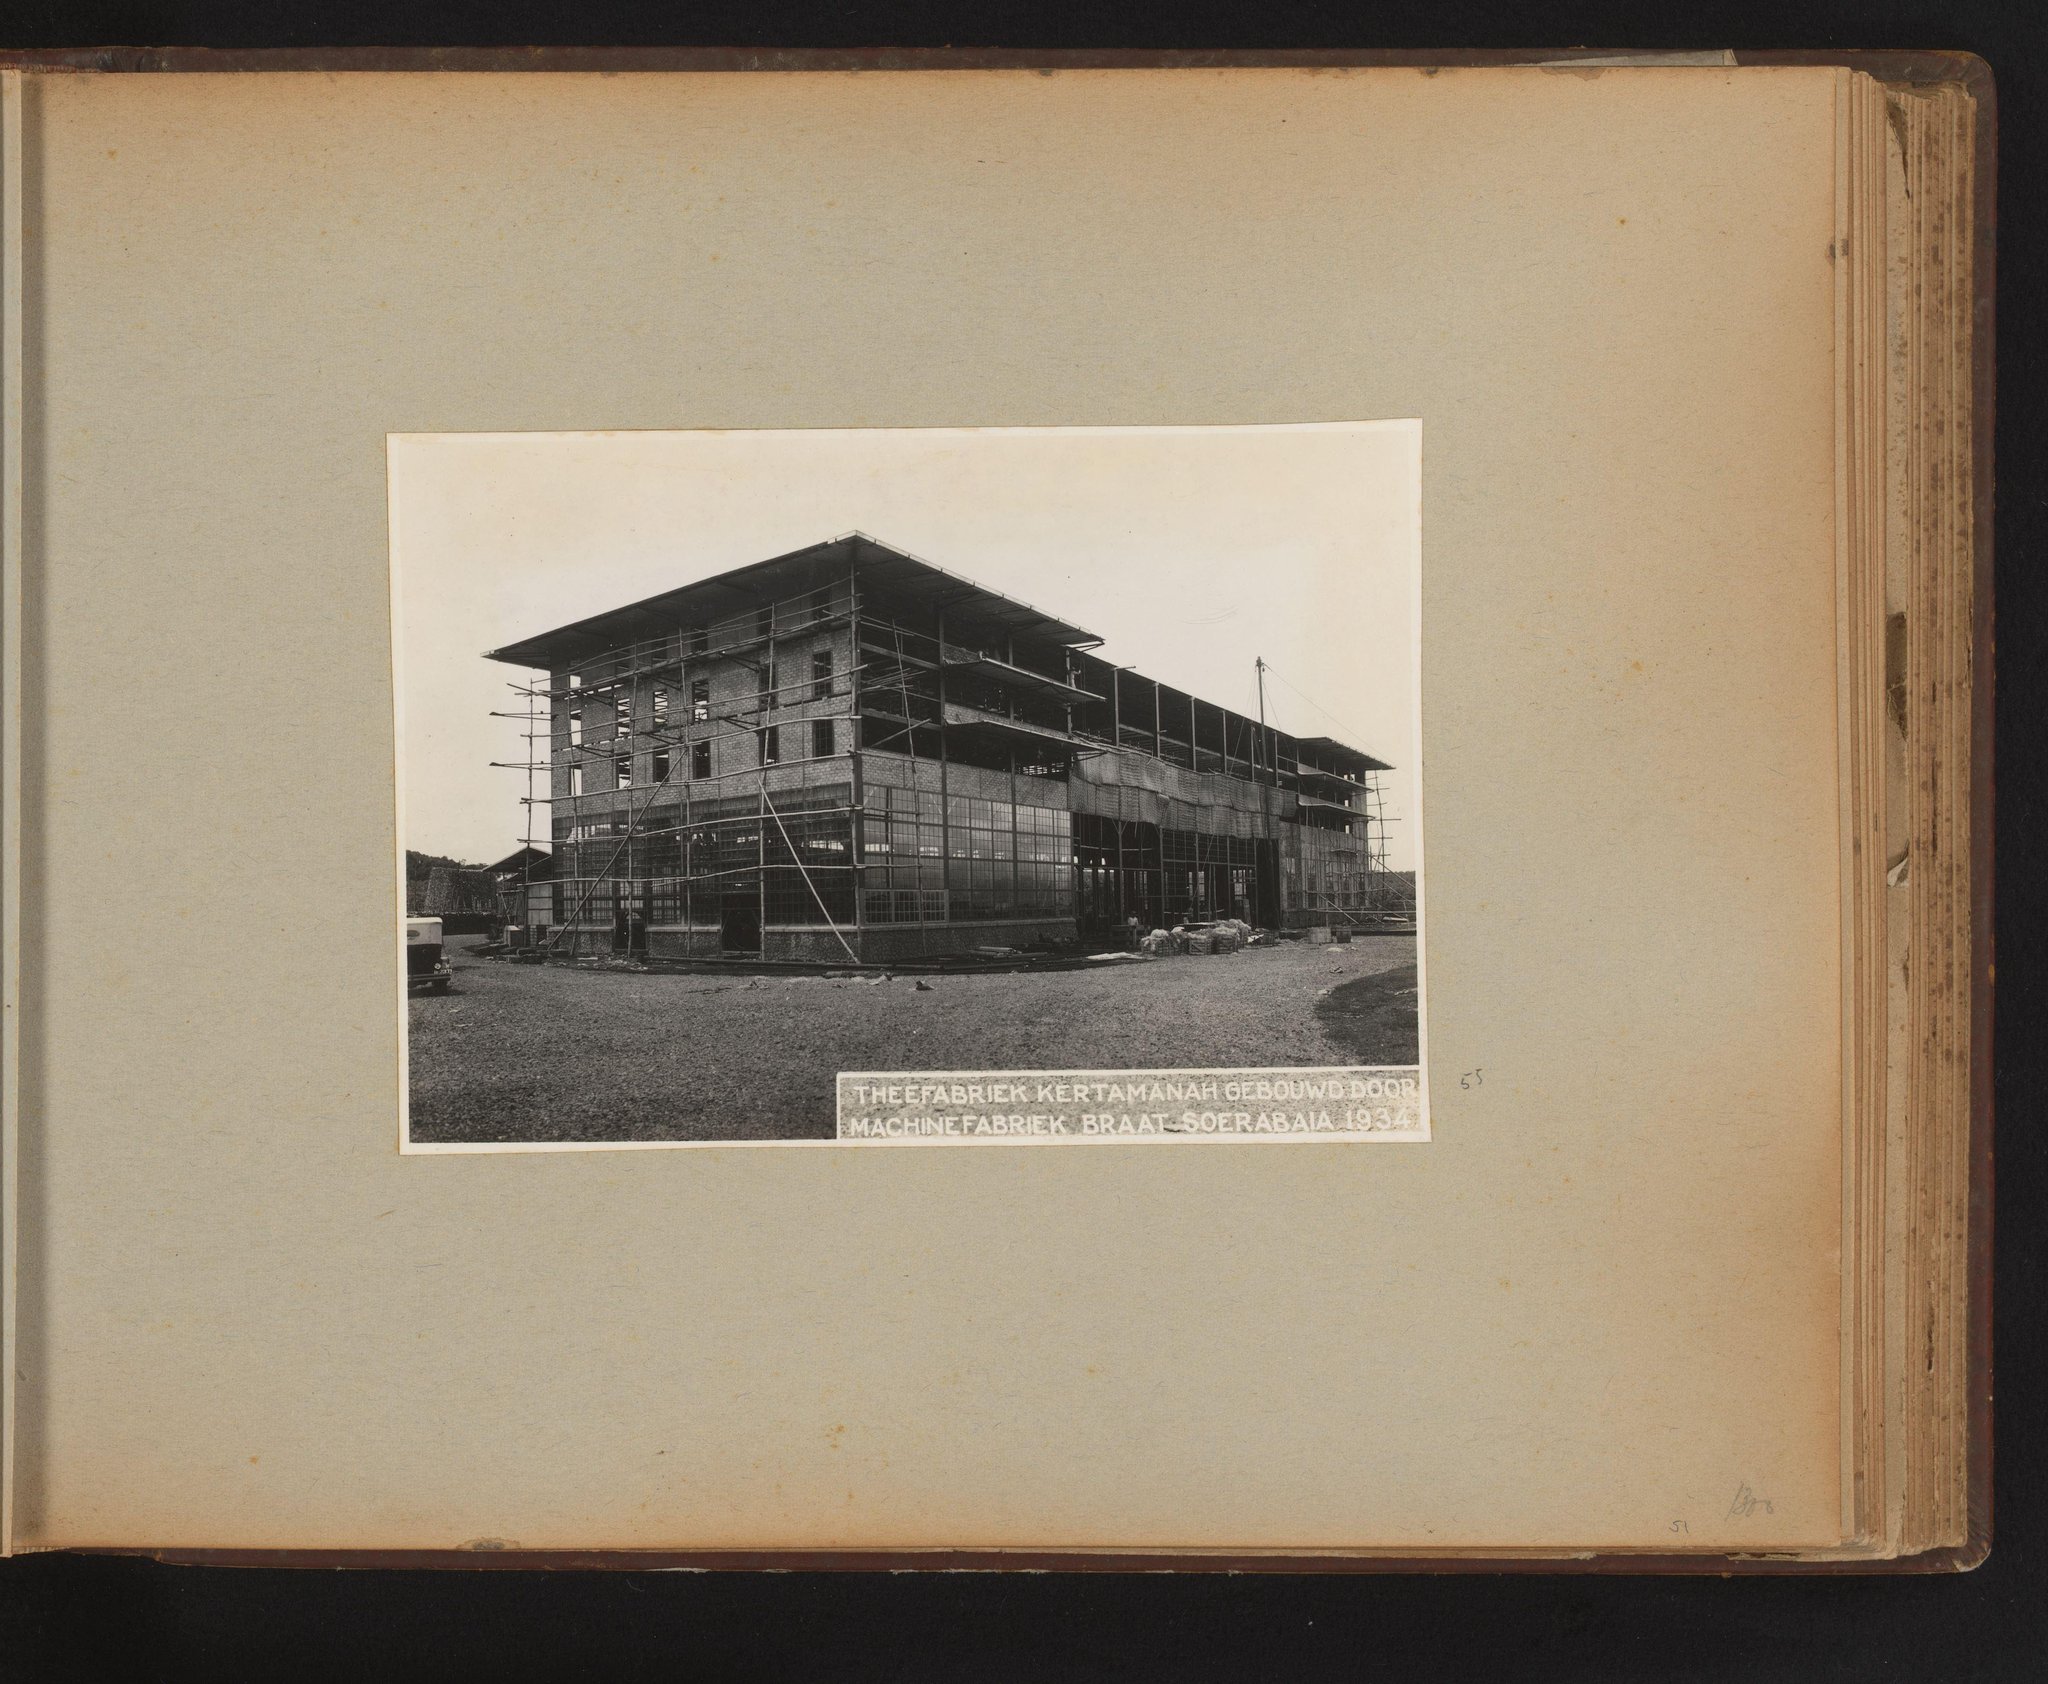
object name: photograph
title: Theefabriek Kertamanah gebouwd door Machinefabriek Braat Soerabaia 1934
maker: Anonymous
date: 1934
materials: cardboard, photographic support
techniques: gelatin silver print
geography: bandung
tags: factory-building, making the overground structures (~ building activities), java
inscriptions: date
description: Albumblad met een foto van de theefabriek Kertamanah ten zuiden van Bandoeng, in aanbouw in 1934. Onderdeel van een fotoalbum met foto's van machines en constructies van de N.V. Machinefabriek Braat te Soerabaja, Soekaboemi en Tegal uit de periode 1931-1937.